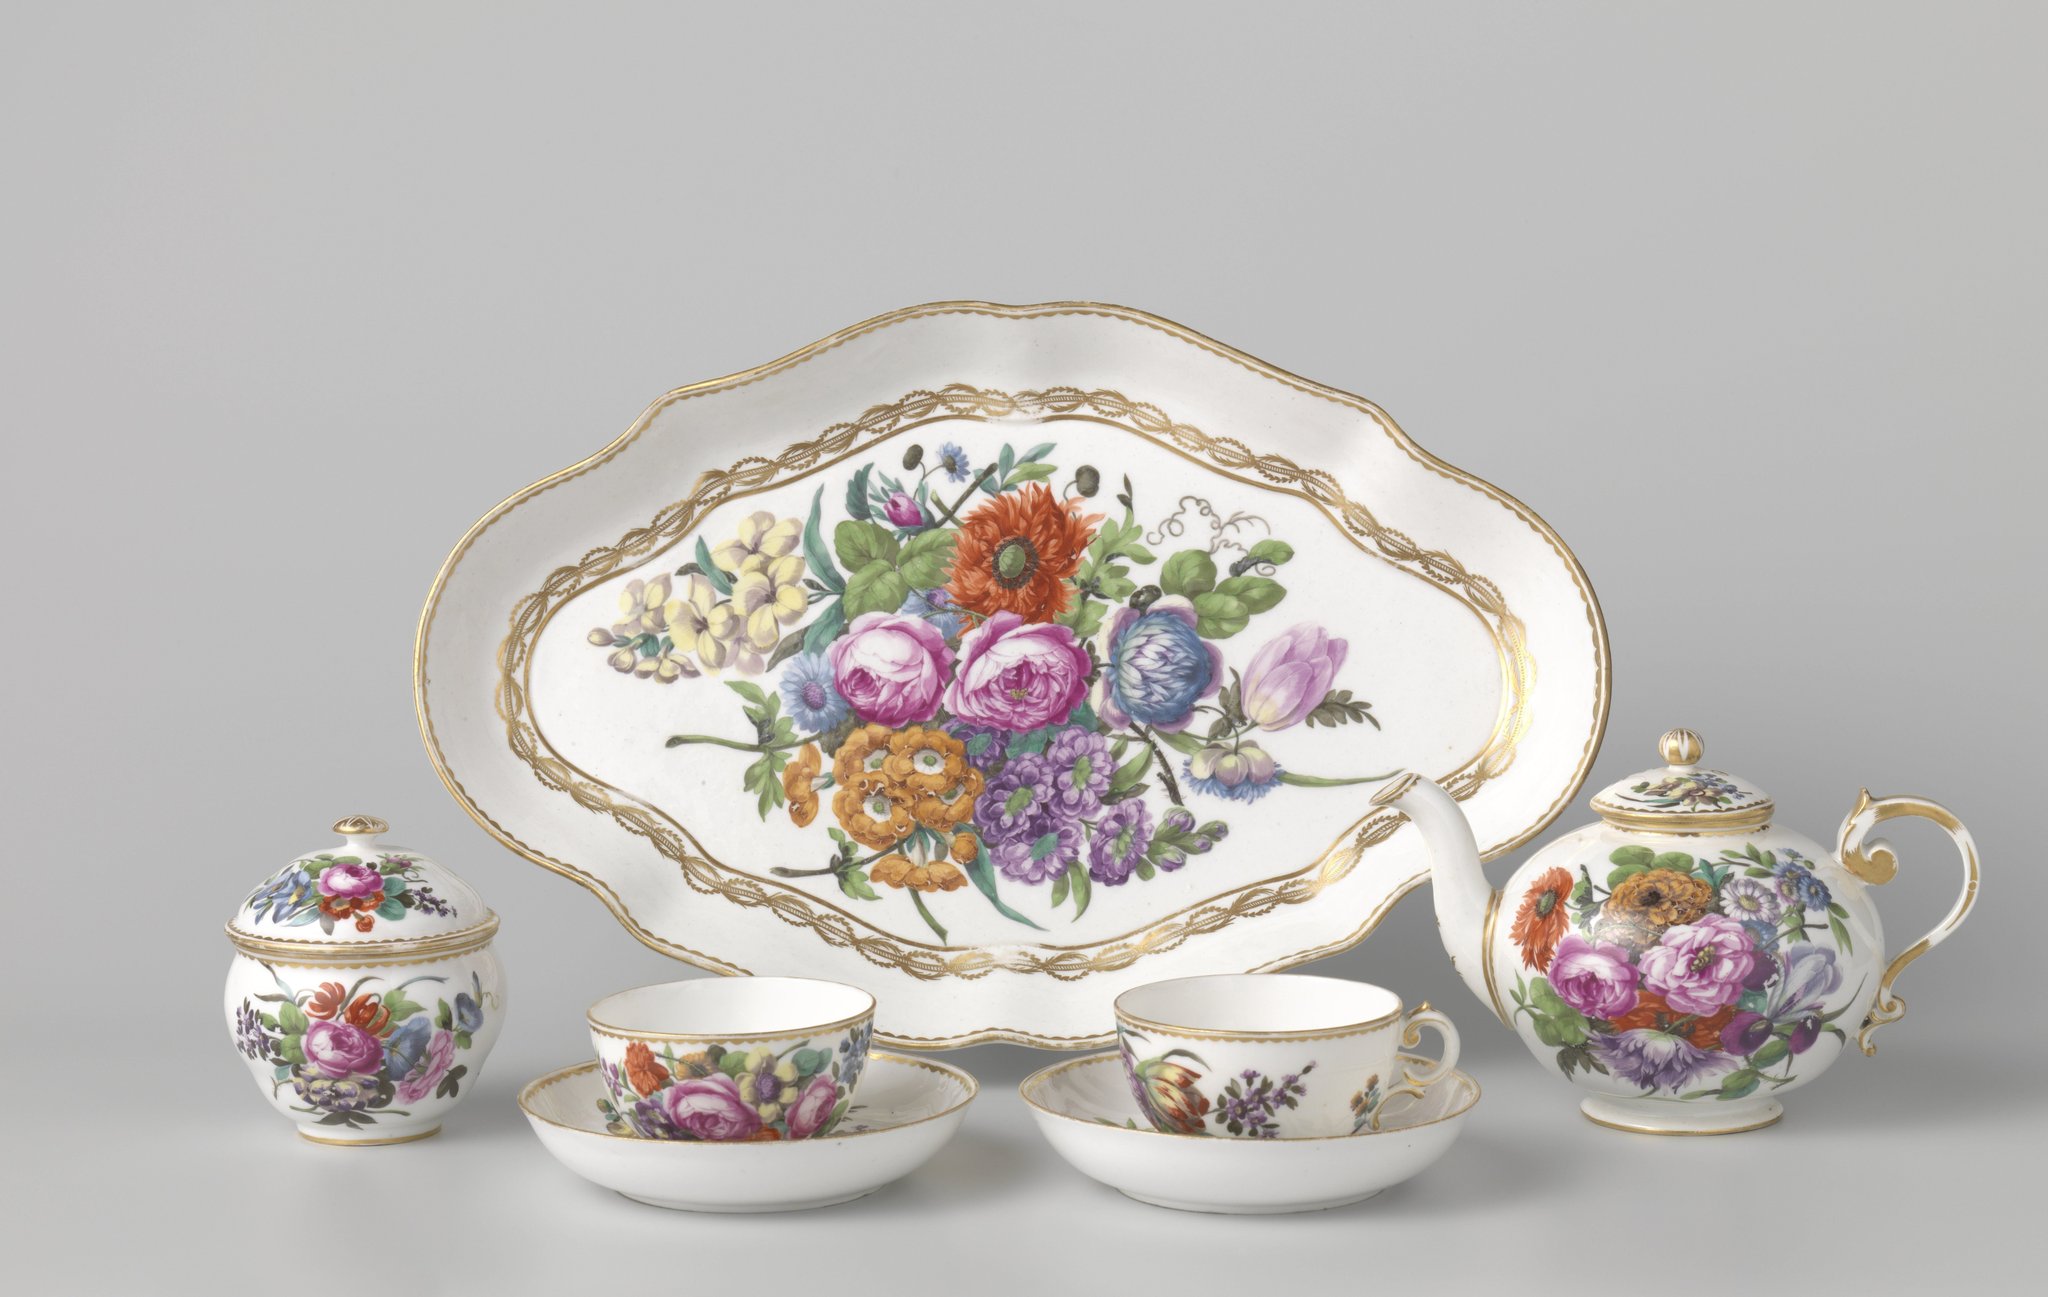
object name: vessel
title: Tête-à-tête, beschilderd met bloemboeketten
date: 1778-1782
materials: porcelain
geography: loosdrecht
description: Déjeuner (small service). Porcelain. Loosdrecht, c. 1778 - 1782. Factory of Joannes de Mol.